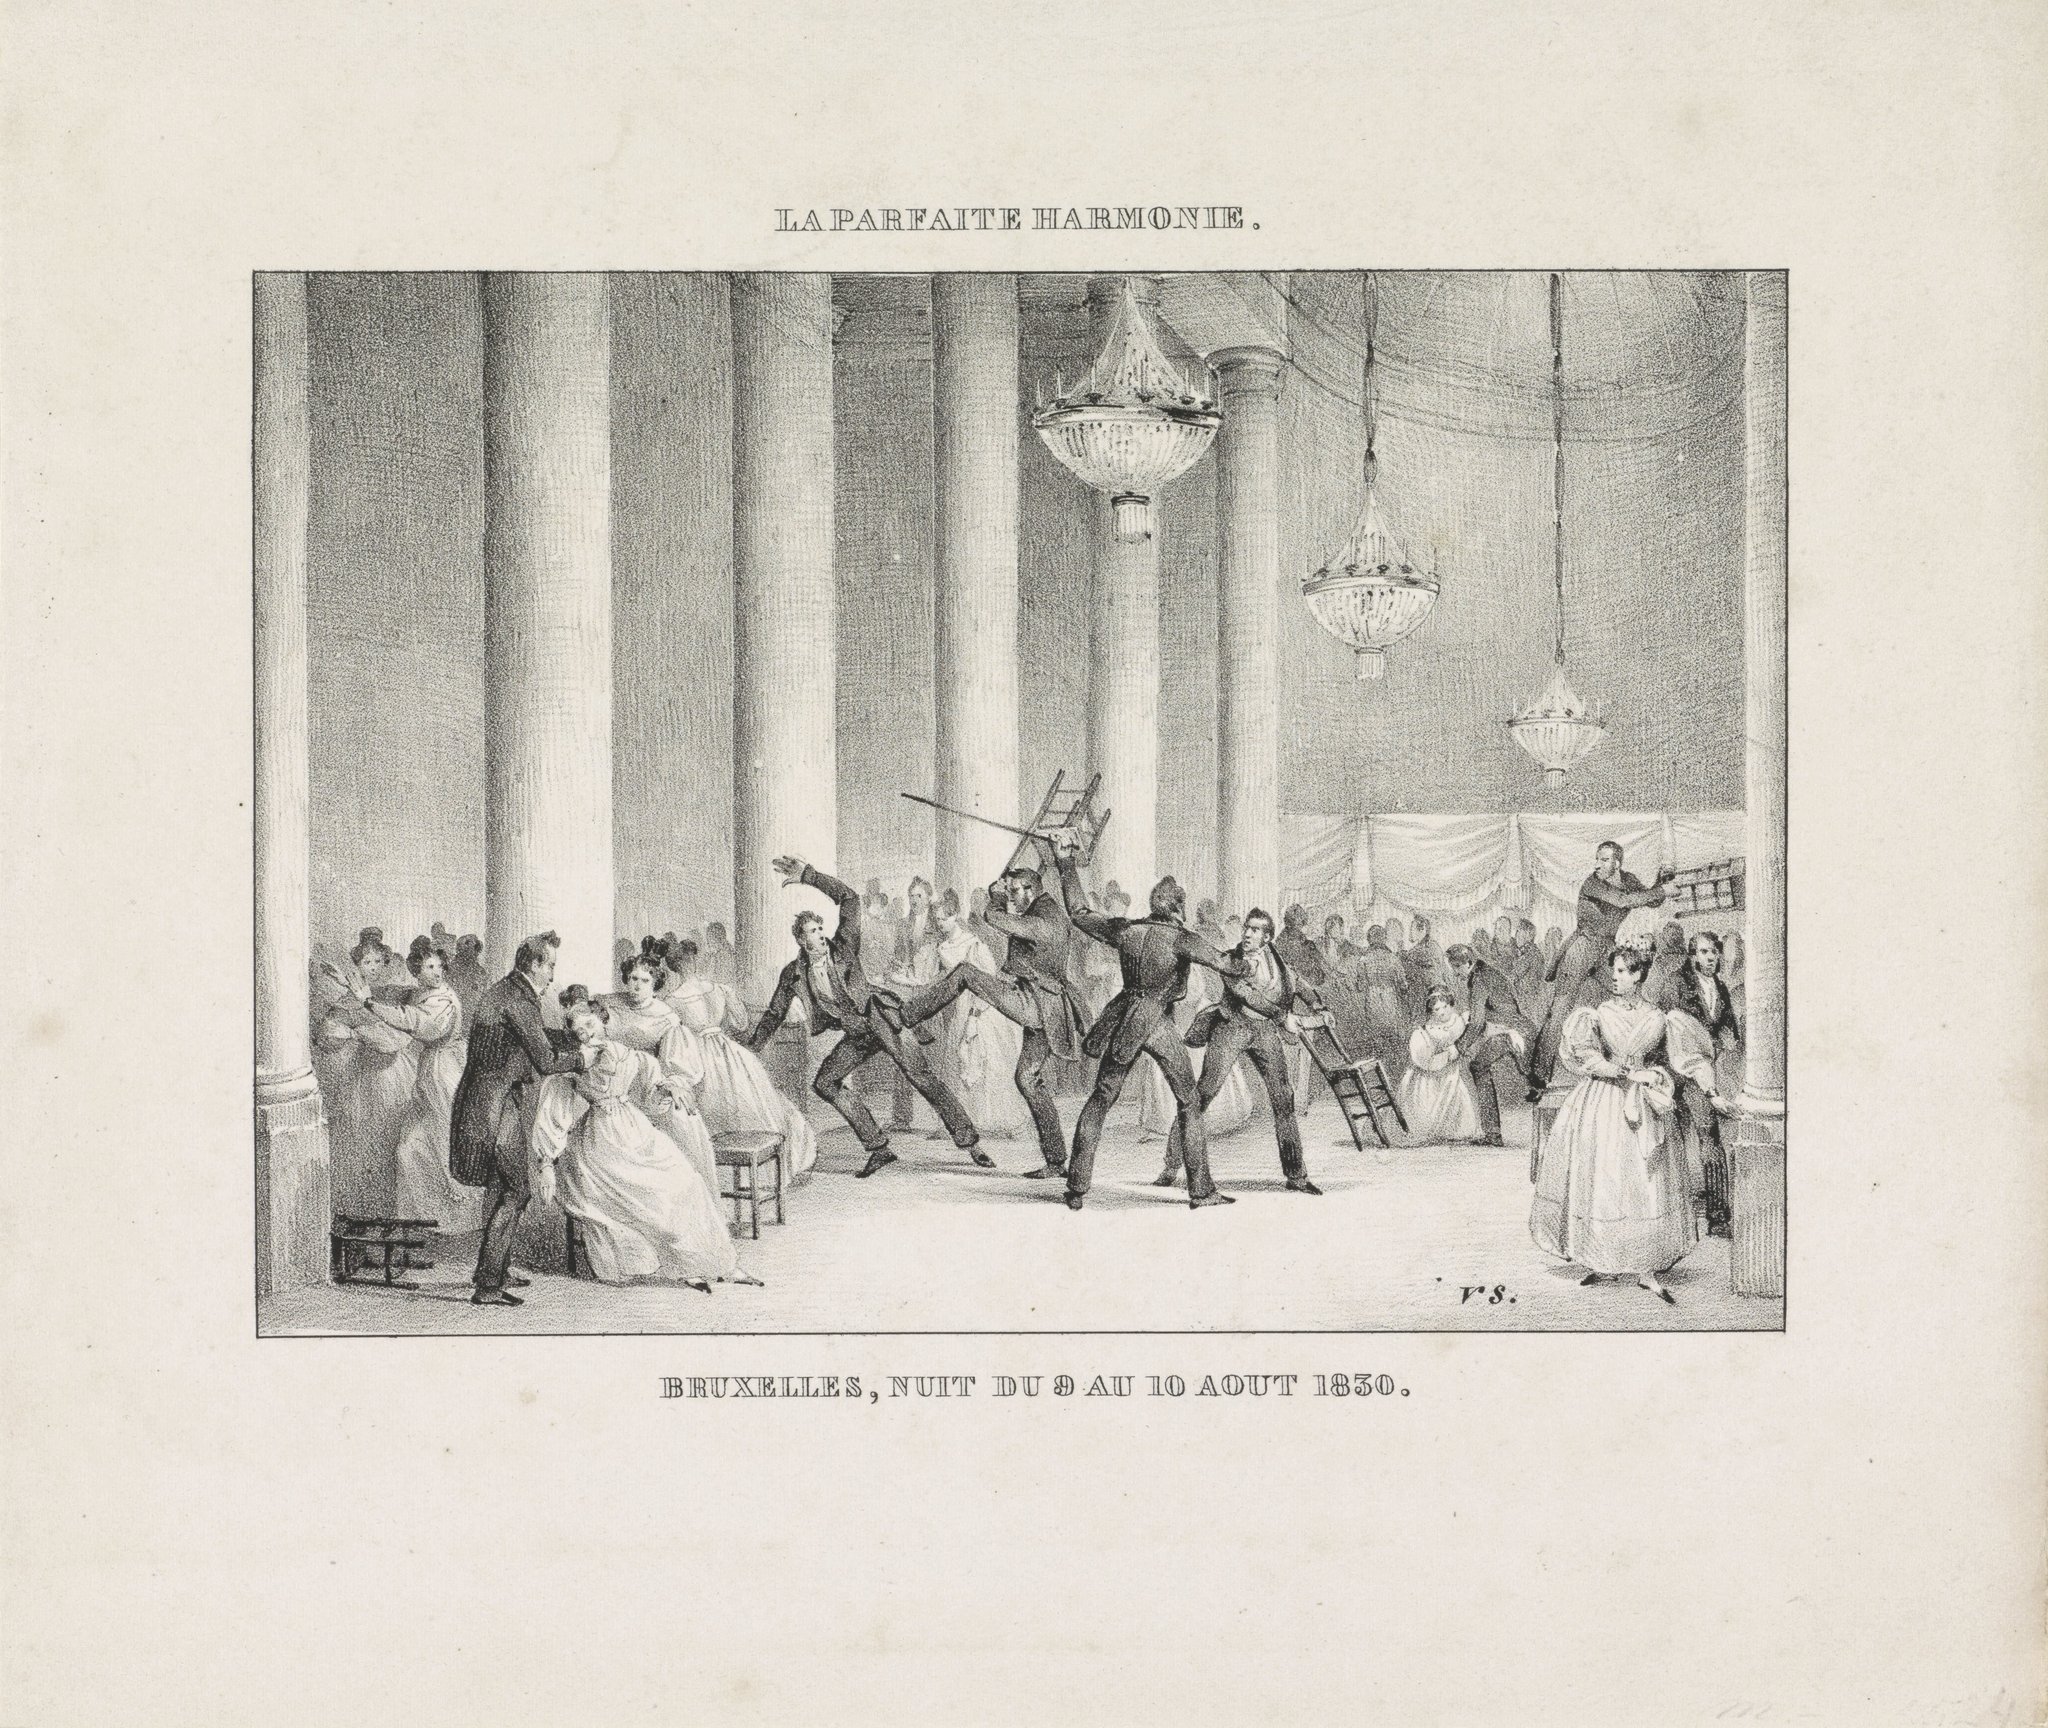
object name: cartoon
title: La Parfaite Harmonie / Bruxelles, nuit du 9 au 10 aout 1830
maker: Anonymous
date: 1830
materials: paper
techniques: lithograph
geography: southern netherlands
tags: concert hall, fighting, brussels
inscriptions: collector's mark: Lugt 2228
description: Spotprent met een vechtpartij tussen vier of vijf mannen uit het publiek in een concertzaal te Brussel, in de nacht van 9 op 10 augustus 1830.